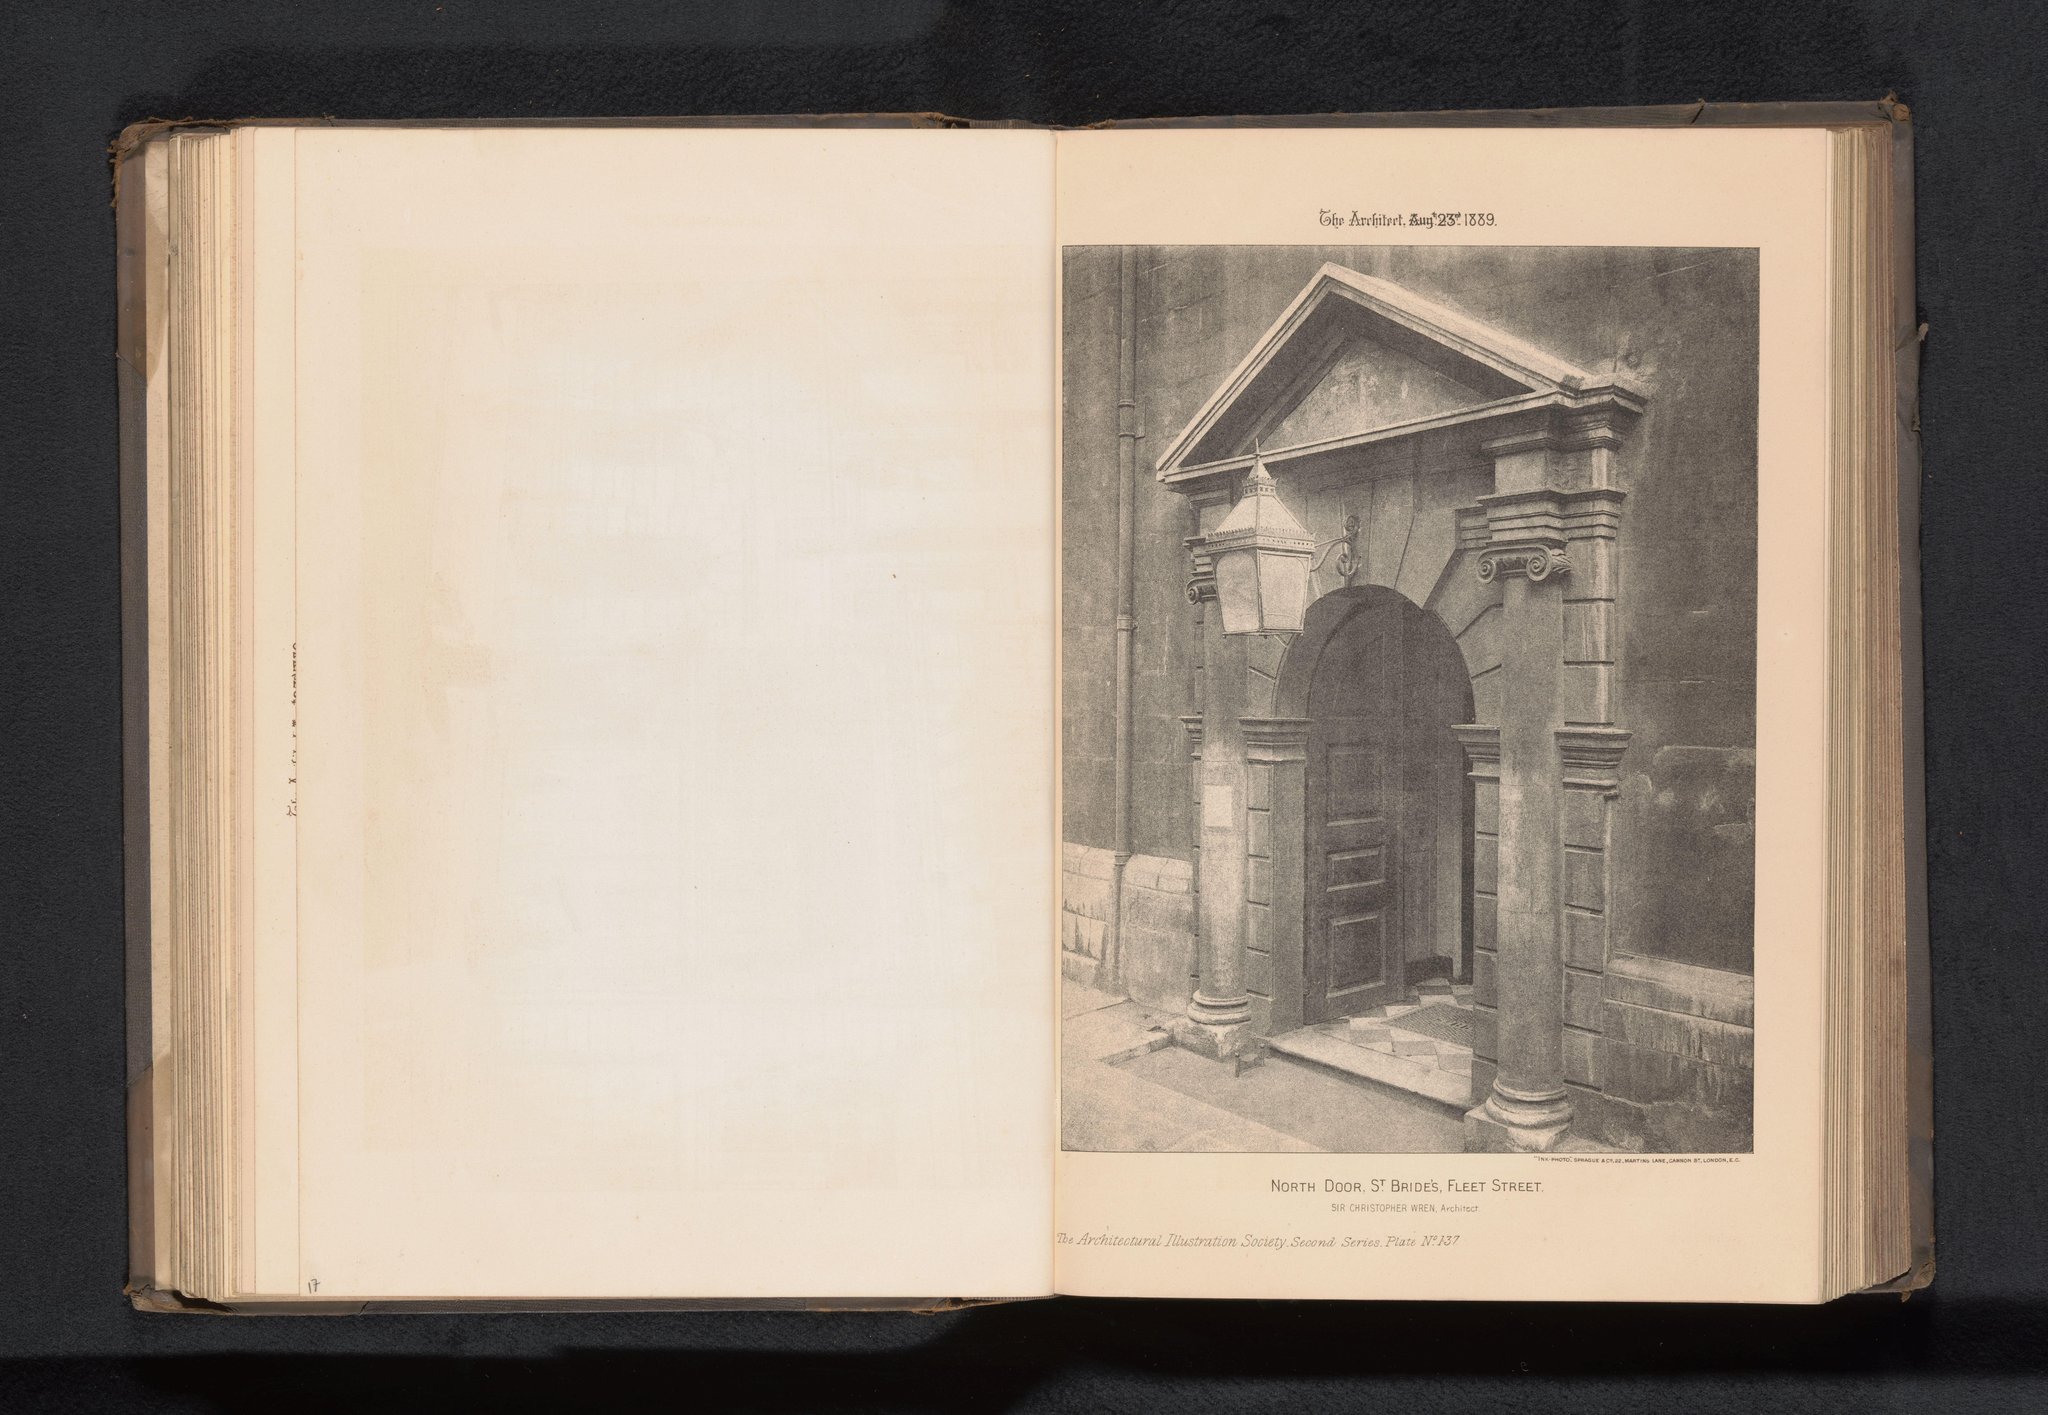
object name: page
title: Ingang van de noordzijde van de St. Bride's Church te Londen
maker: Anonymous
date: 1884-1889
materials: paper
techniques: photolithography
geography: london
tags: parts of church exterior and annexes (door), london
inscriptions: inscription: ‘Sir Christopher Wren, Architect/ The Architectural Illustration Society. Second Series. Plate No.137’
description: Prent op negende ongenummerde pagina na pagina 104.